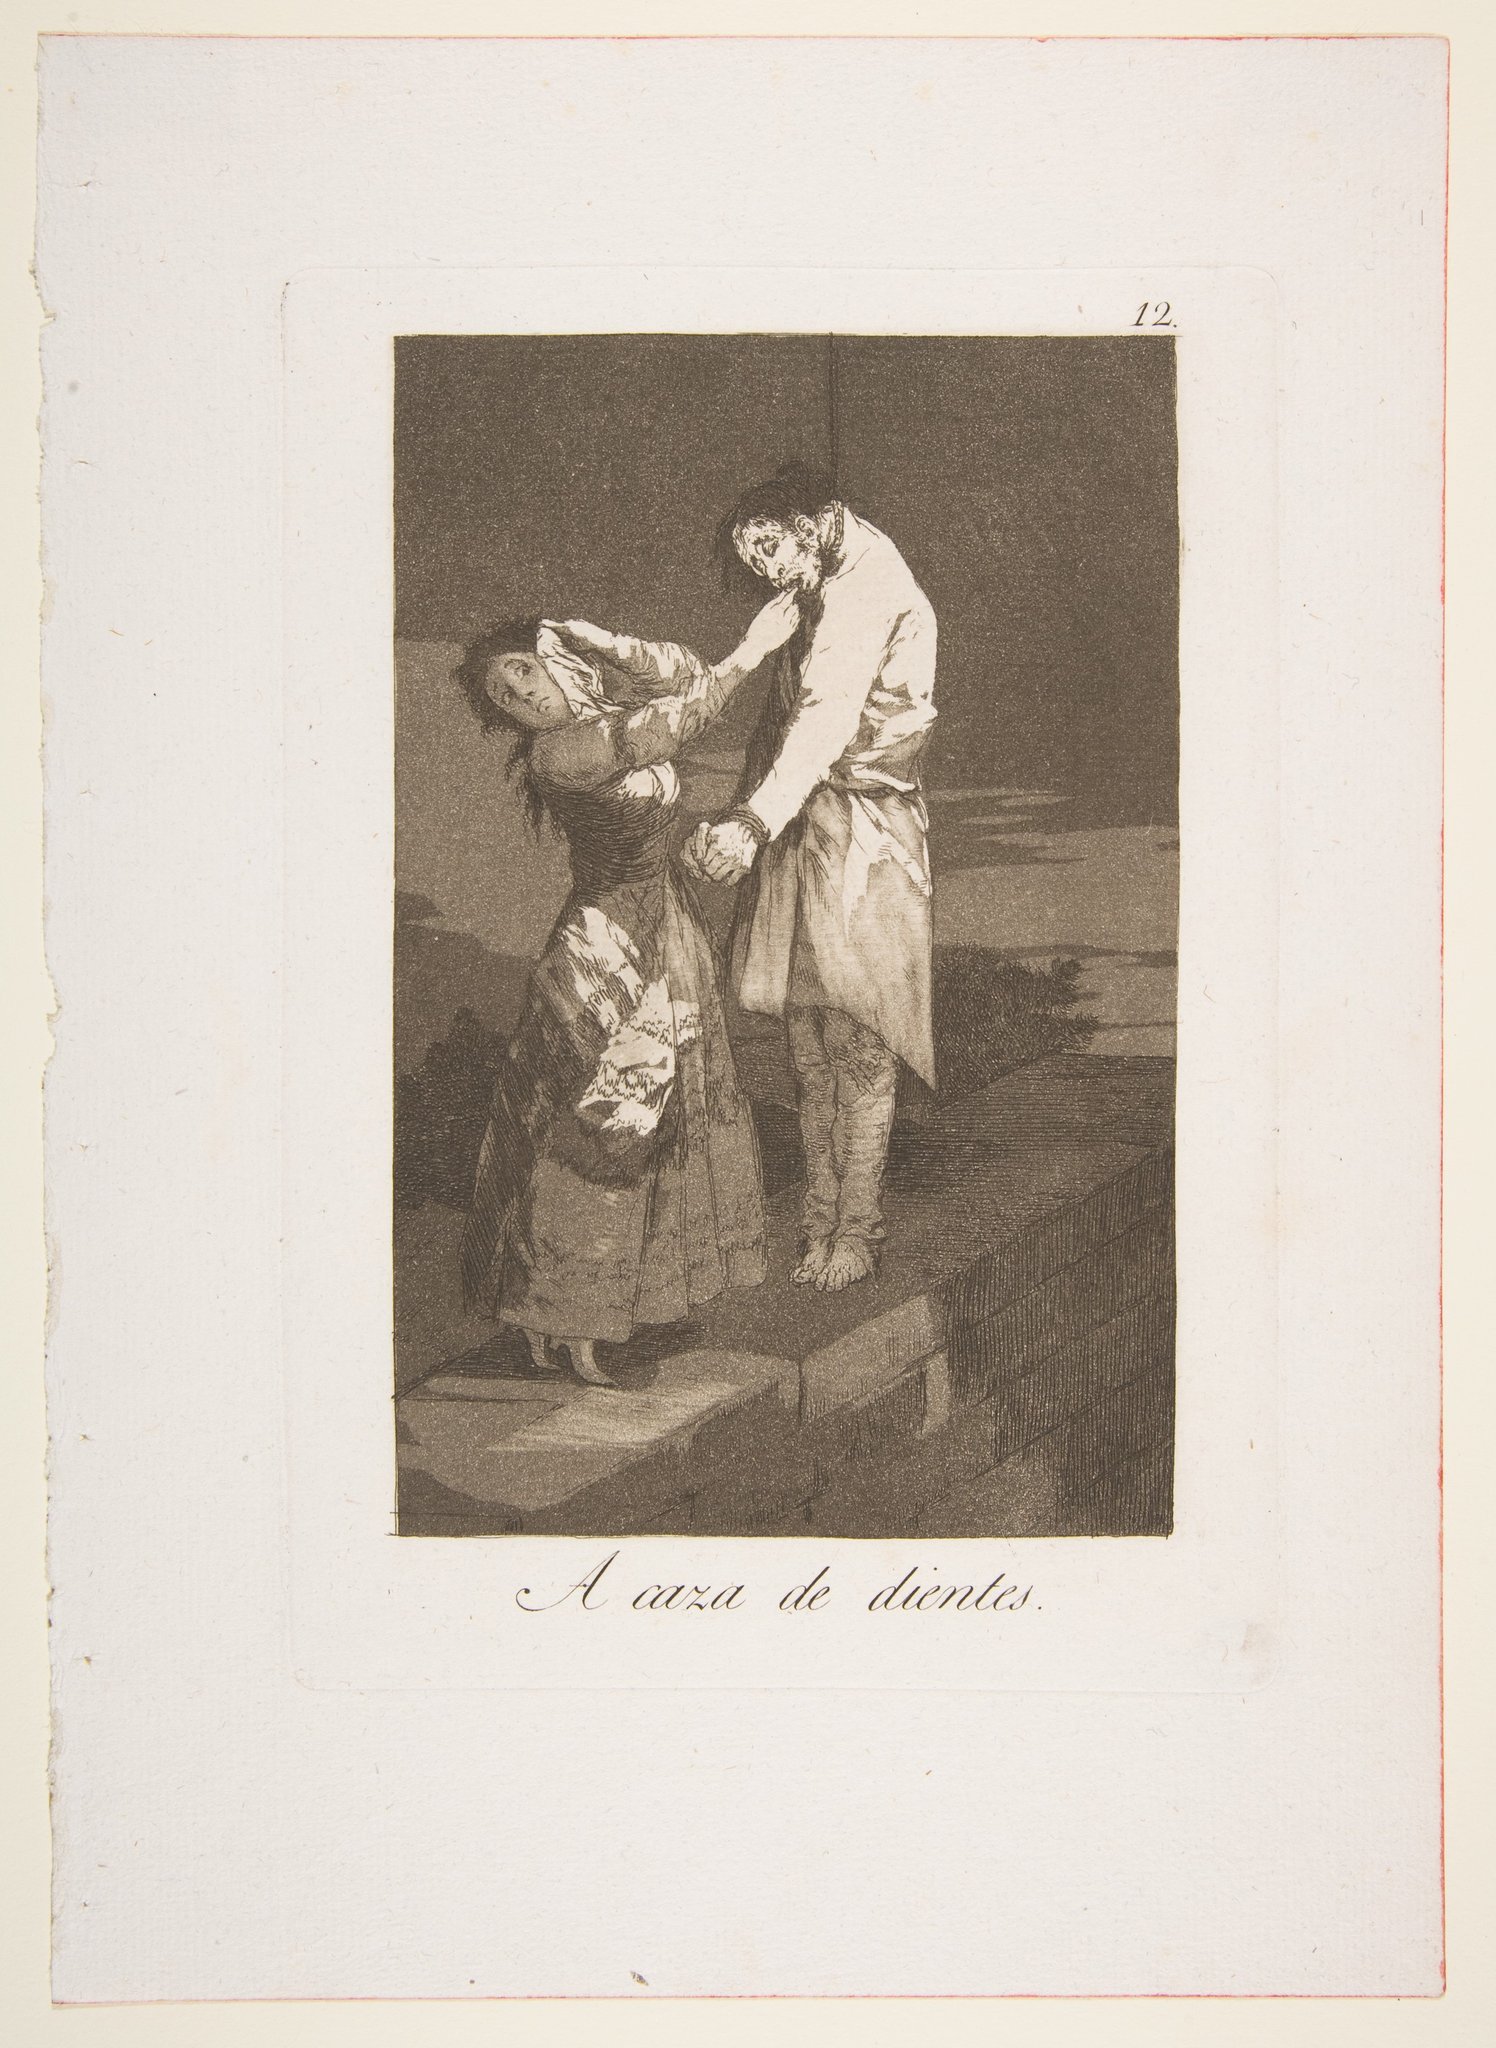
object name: print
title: Plate 12 from "Los Caprichos": Out hunting for teeth (A caza de dientes)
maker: goya (francisco de goya y lucientes)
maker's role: artist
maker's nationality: spanish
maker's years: 1746-1828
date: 1799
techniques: aquatint, engraving, burnishing, etching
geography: spain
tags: men,women,death